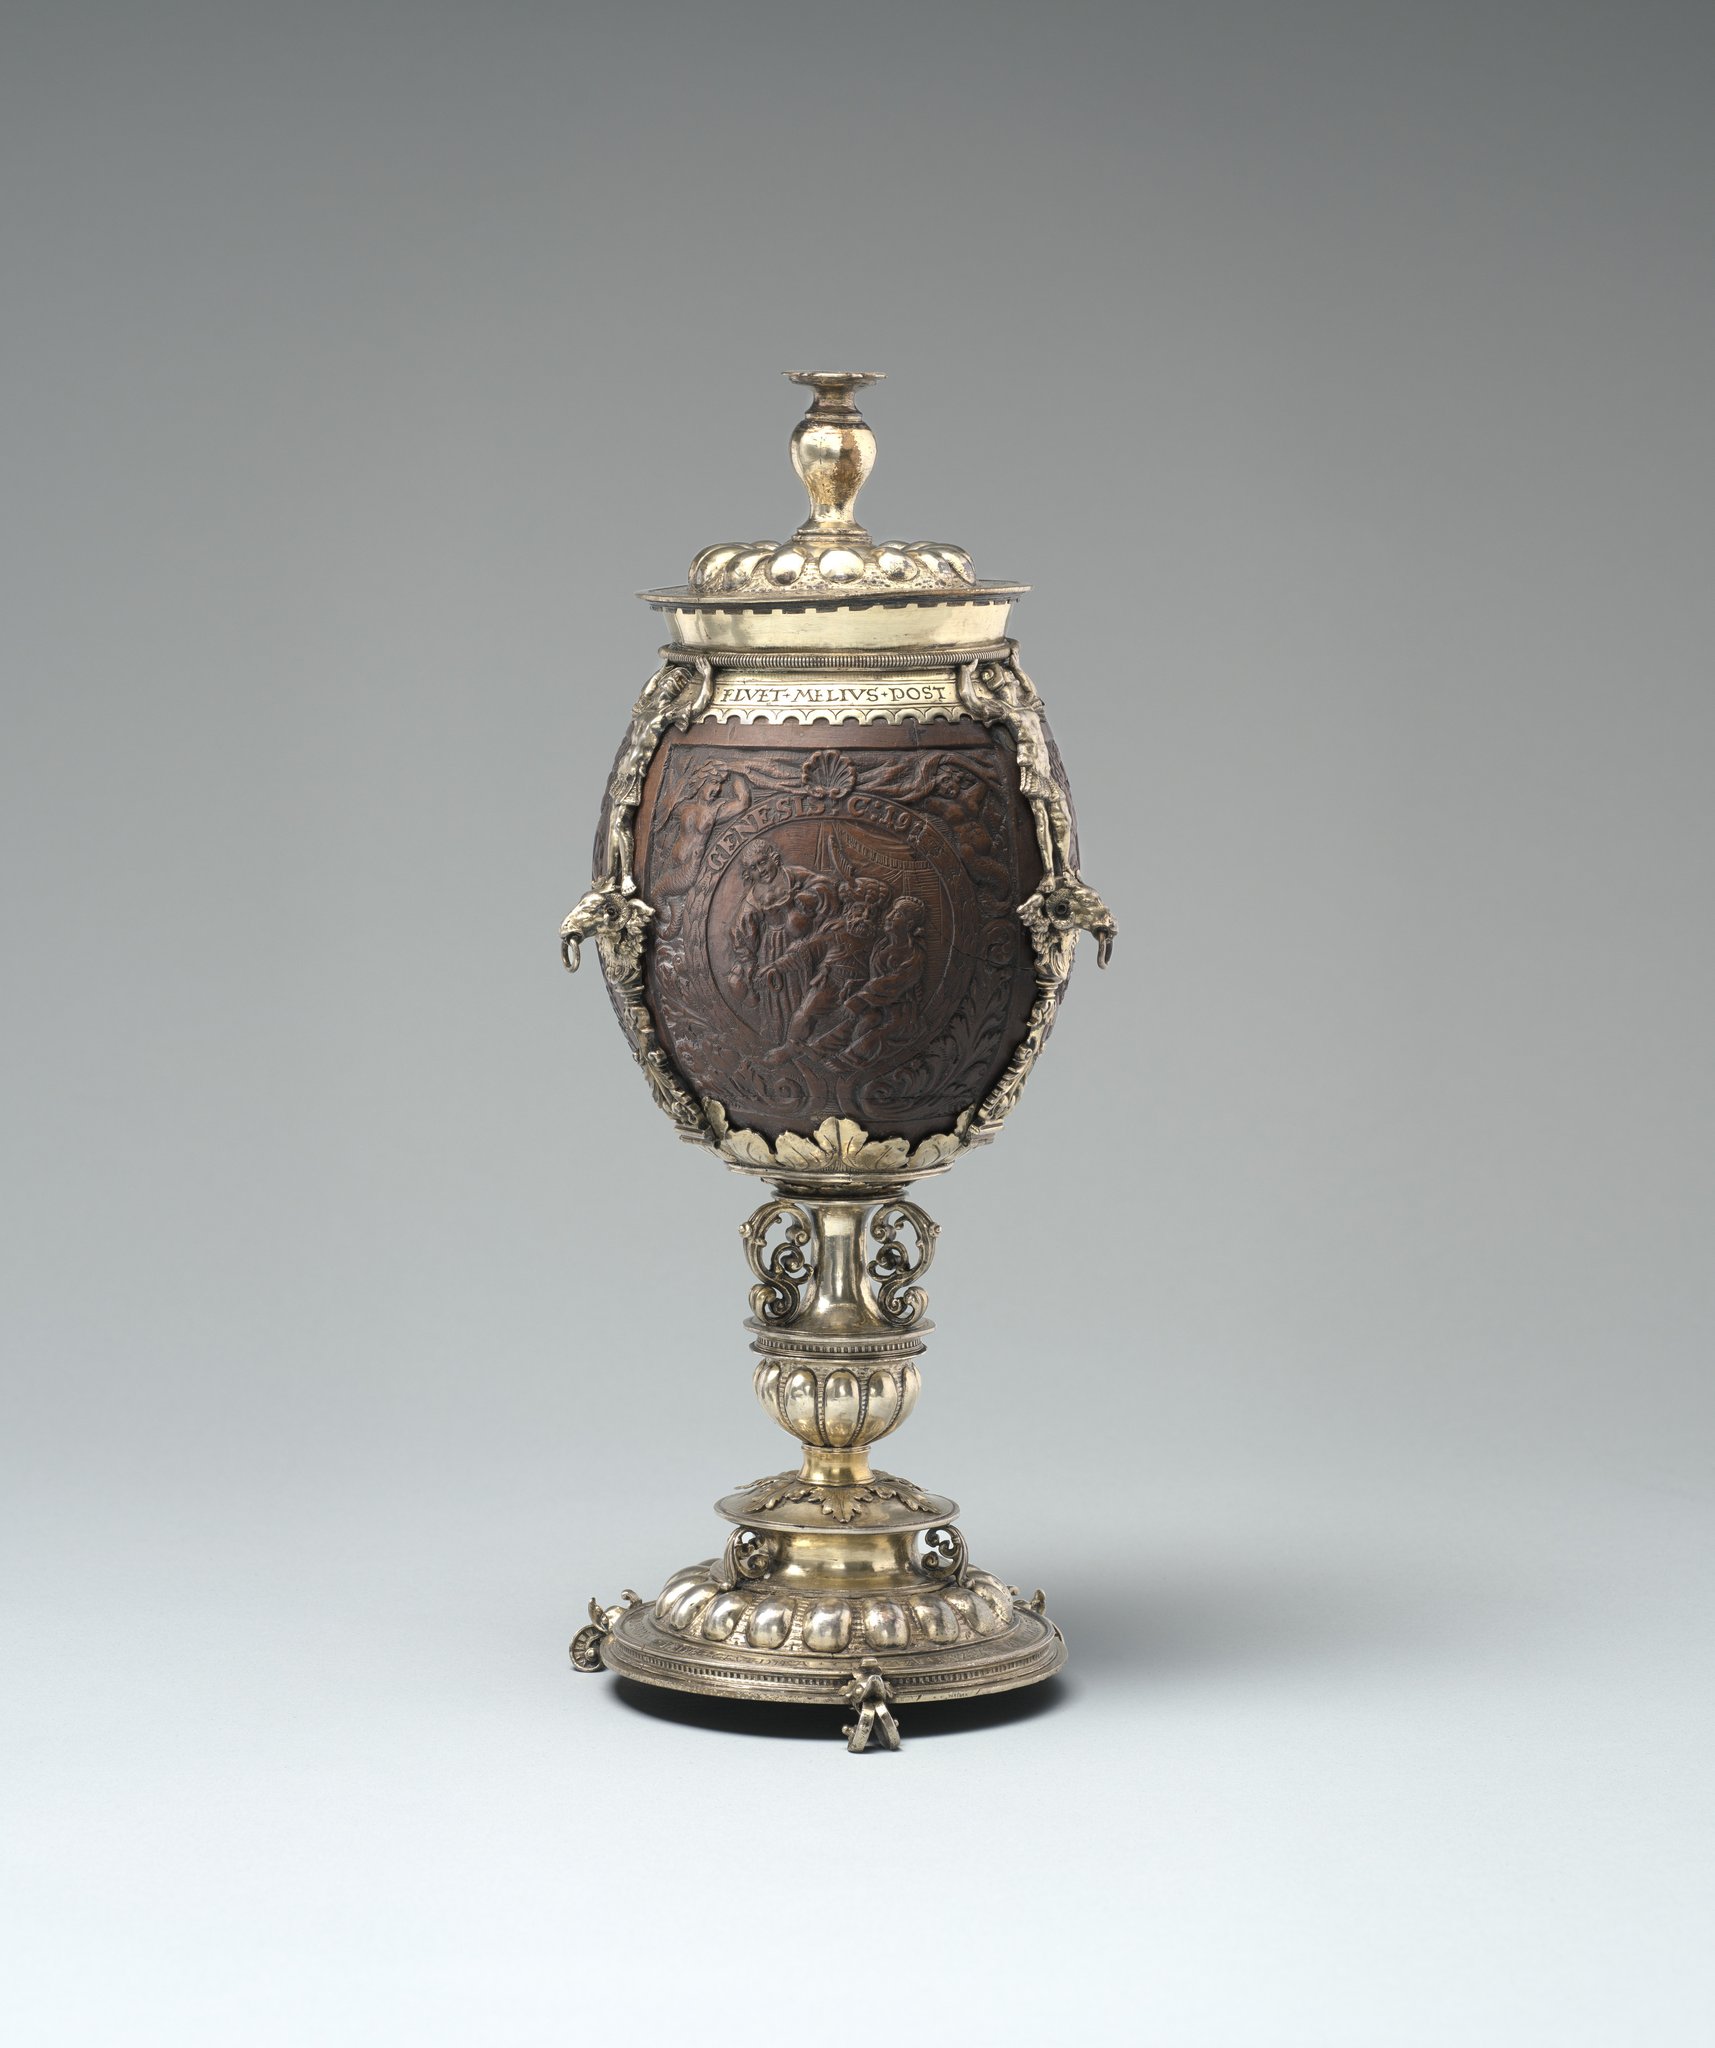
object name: cup with cover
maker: hans van amsterdam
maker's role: maker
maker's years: 1535-1565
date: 1533-1534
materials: plant material, gilt silver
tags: fruit,men,women,bathsheba